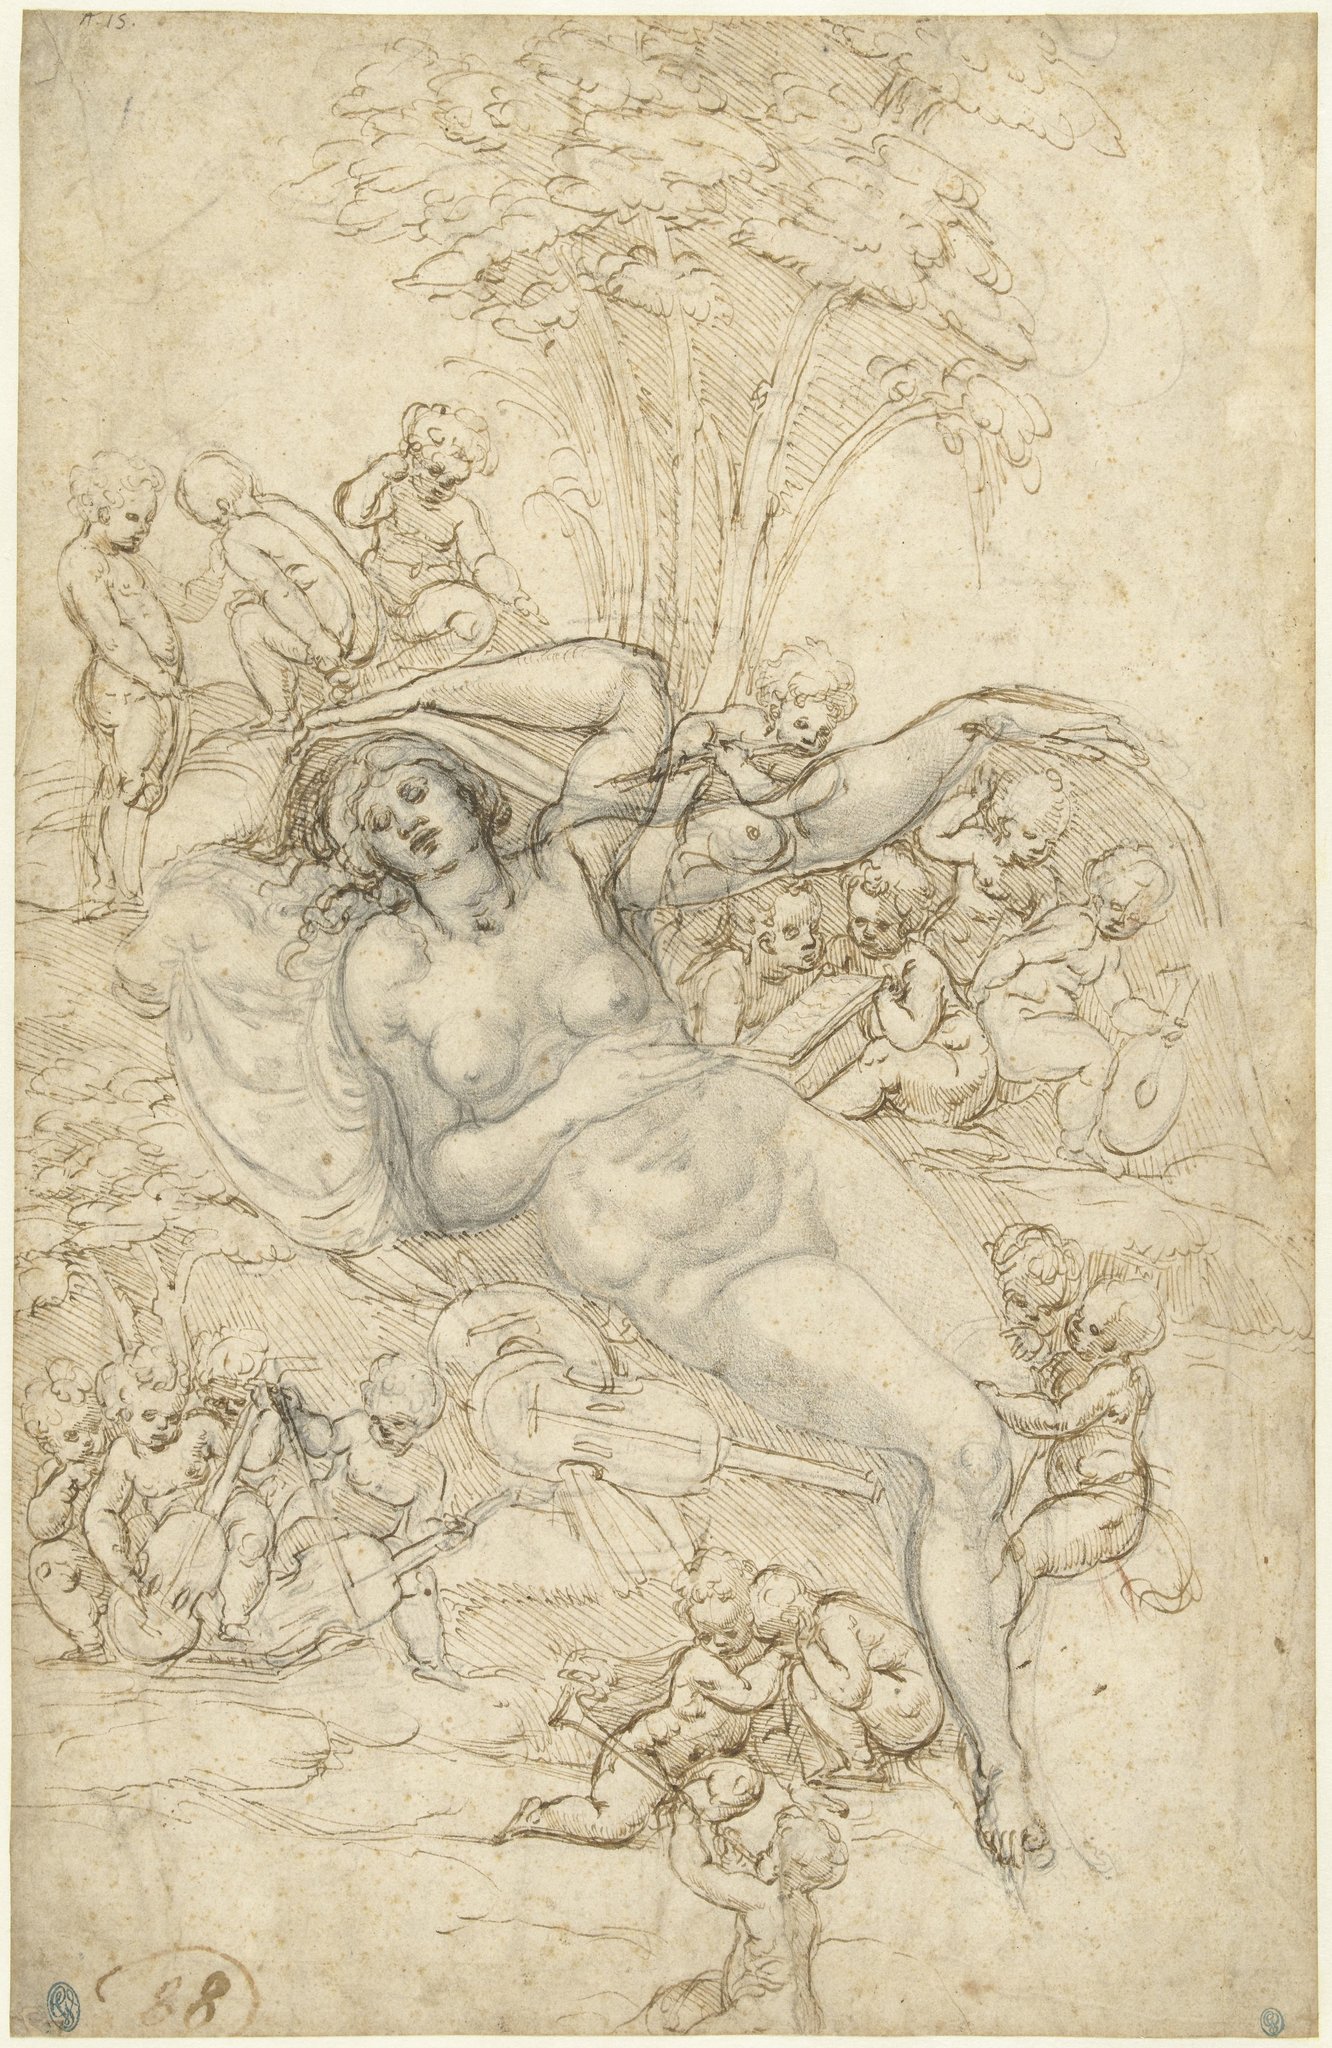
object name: drawing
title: Slapende naakte vrouw en spelende kinderen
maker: raffaele da montelupo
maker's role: draughtsman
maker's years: 1505-1567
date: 1520-1540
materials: chalk, ink, paper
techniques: pen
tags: sleeping; unconsciousness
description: Slapende naakte vrouw met een boek, onder een boom, omgeven door spelende kinderen.